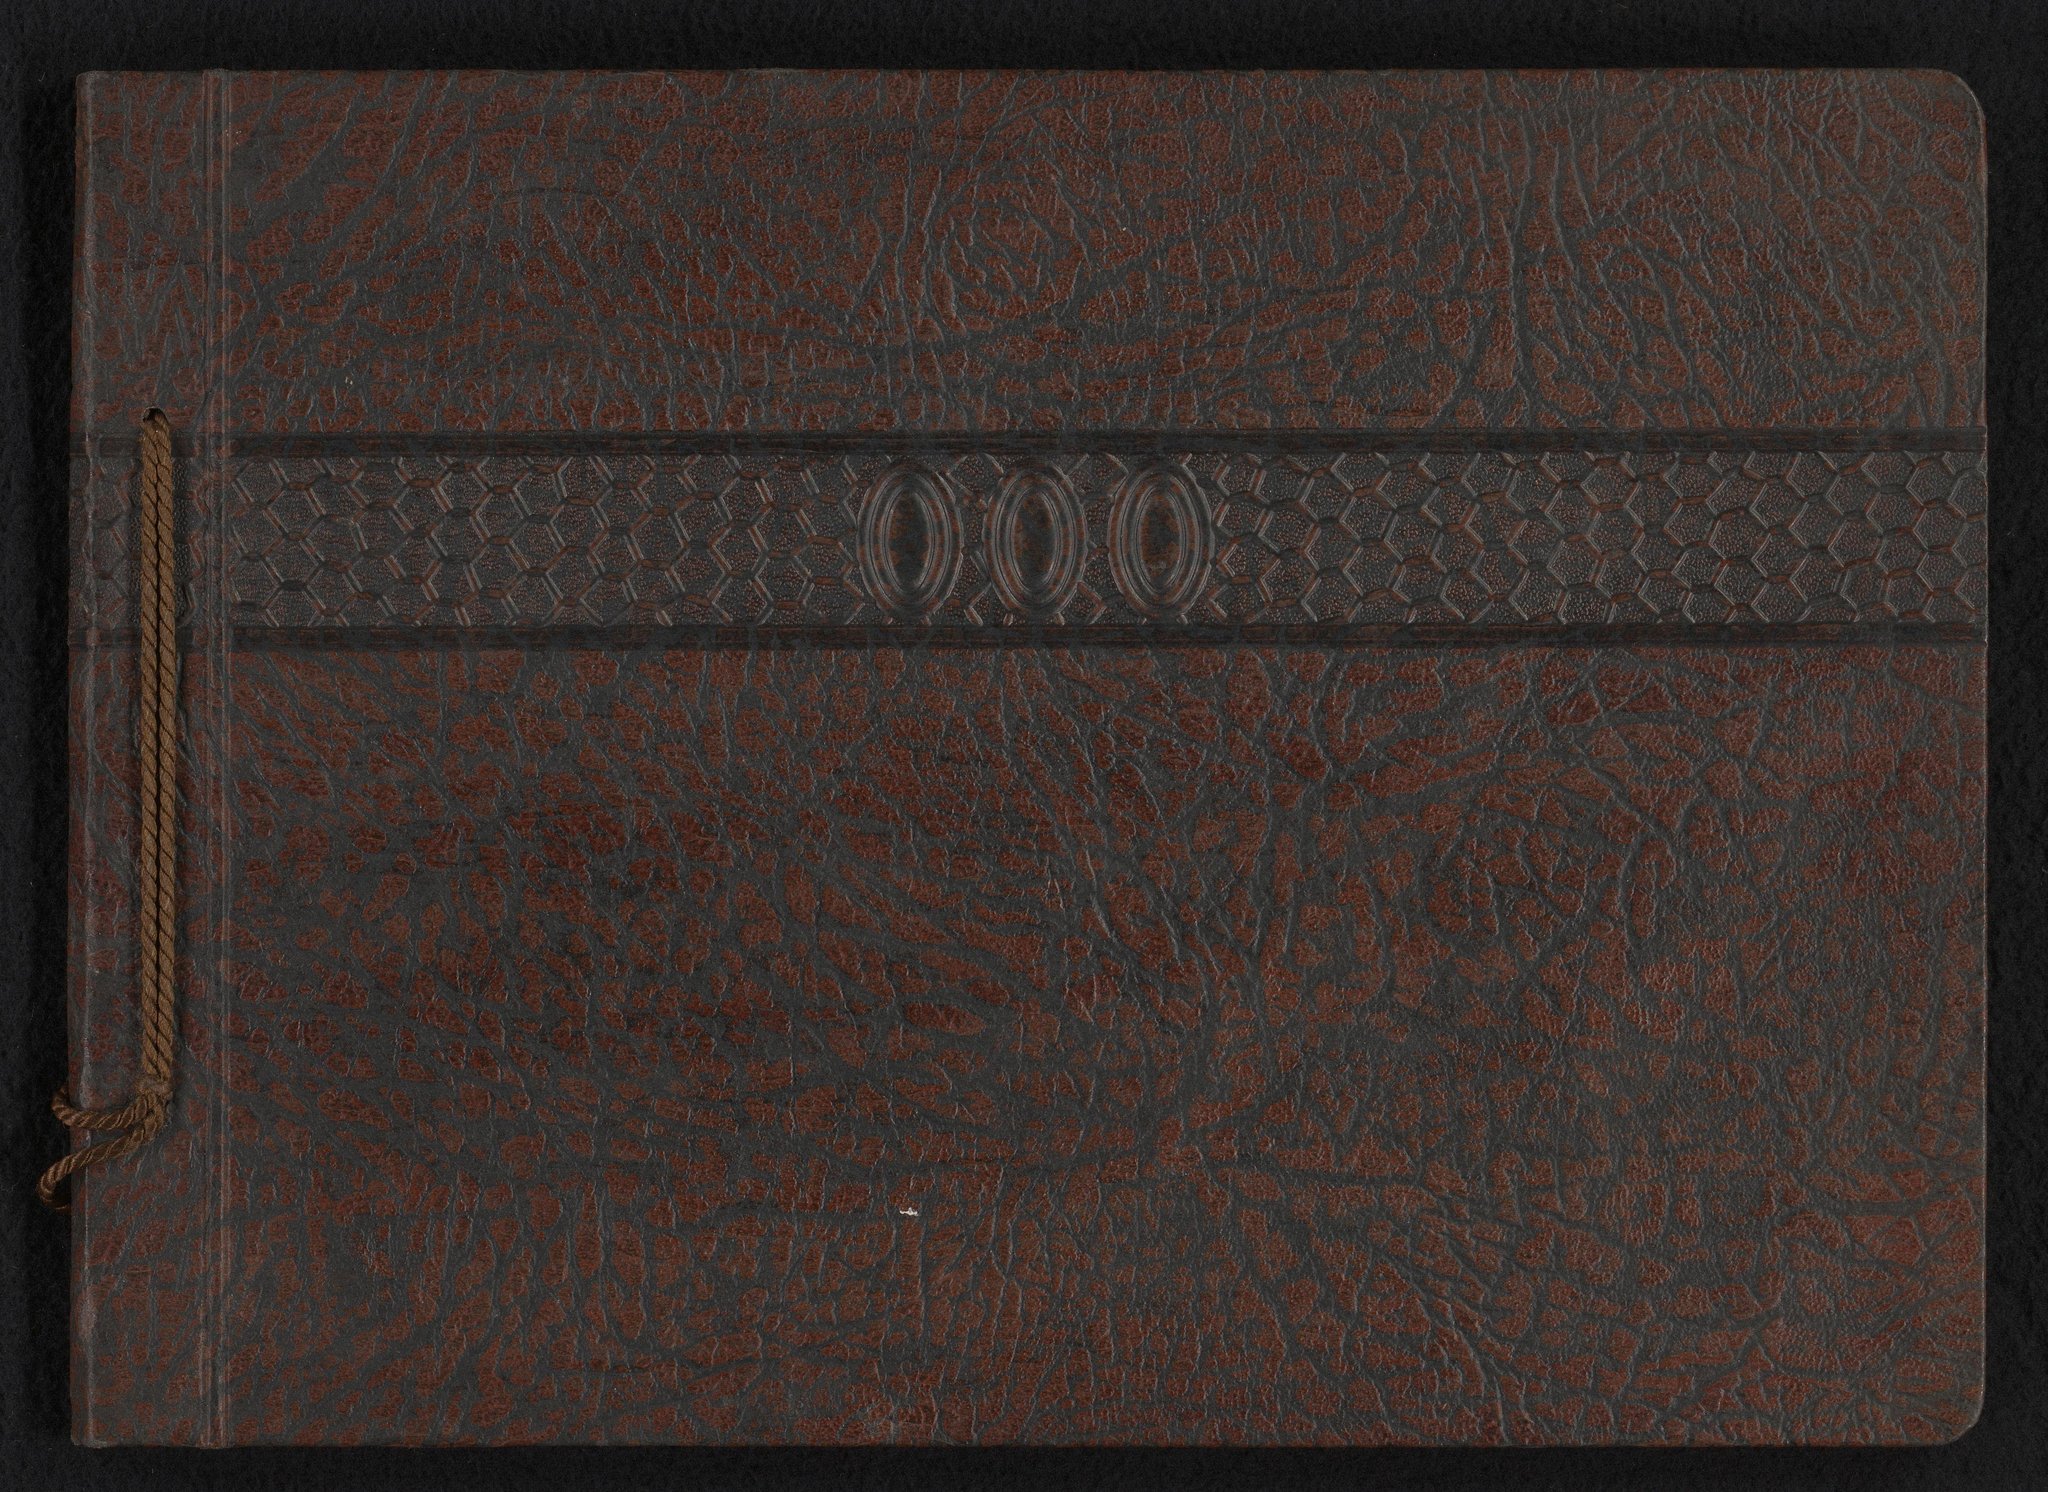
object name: photograph album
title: Fotoalbum kindertijd Eef Dumas op reis door Europa, ca. 1919-1923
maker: frédéric gabriël dumas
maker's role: engineer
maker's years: 1886-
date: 1919-1923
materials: cardboard, photographic support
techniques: albumen print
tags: surabaya, engineer, frédéric gabriël dumas, beatrice jacqueline eveline dumas, java, girl (child between toddler and youth), travelling; tourism, family life at home, outing, pleasure trip, paris, europe, switzerland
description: Fotoalbum over de kindertijd van Beatrice Jacqueline Eveline (Eef) Dumas met de familie op reis door Europa, ca. 1919-1923. Het album bevat in totaal twaalf bladen waarvan tien met in totaal 60 ingeplakte foto's. De meeste foto's zijn waarschijnlijk door haar vader Frédéric Gabriël Dumas gemaakt. Achterin een envelop met drie negatieven.